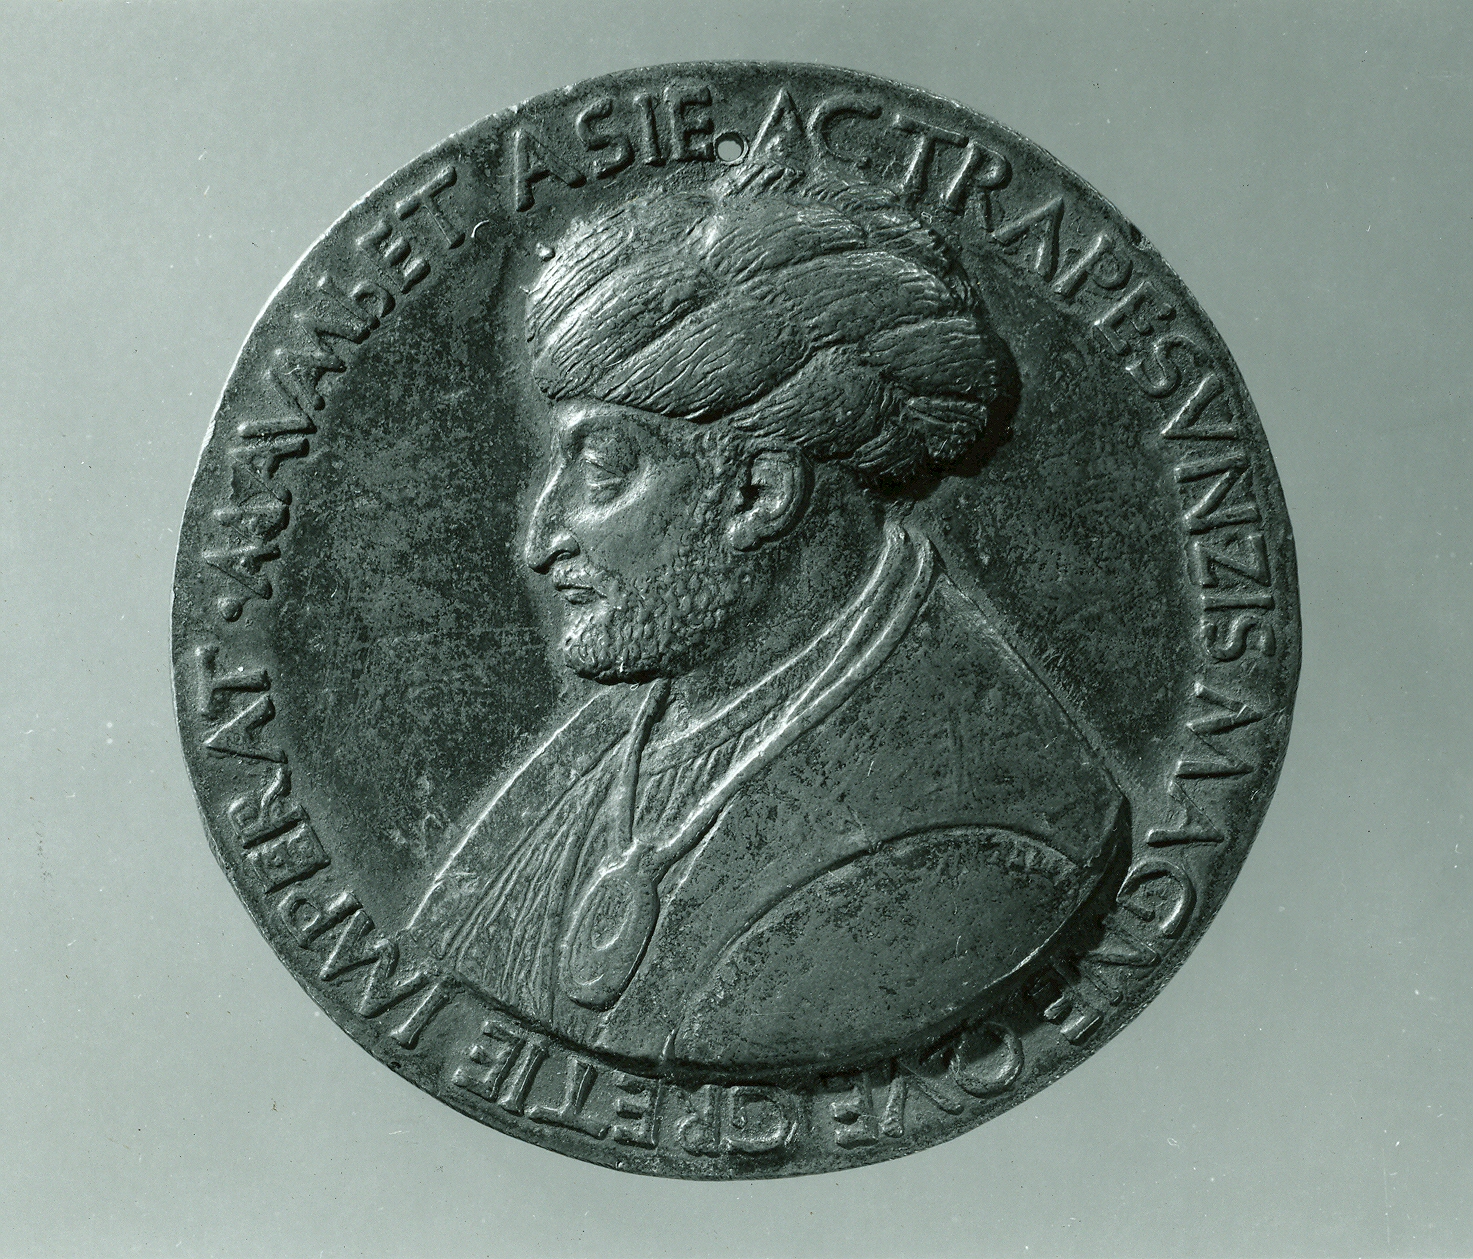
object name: medal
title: Medal: Sultan Mehmed II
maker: bertoldo di giovanni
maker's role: artist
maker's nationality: italian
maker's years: 1430-1491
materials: copper alloy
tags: men,portraits,profiles